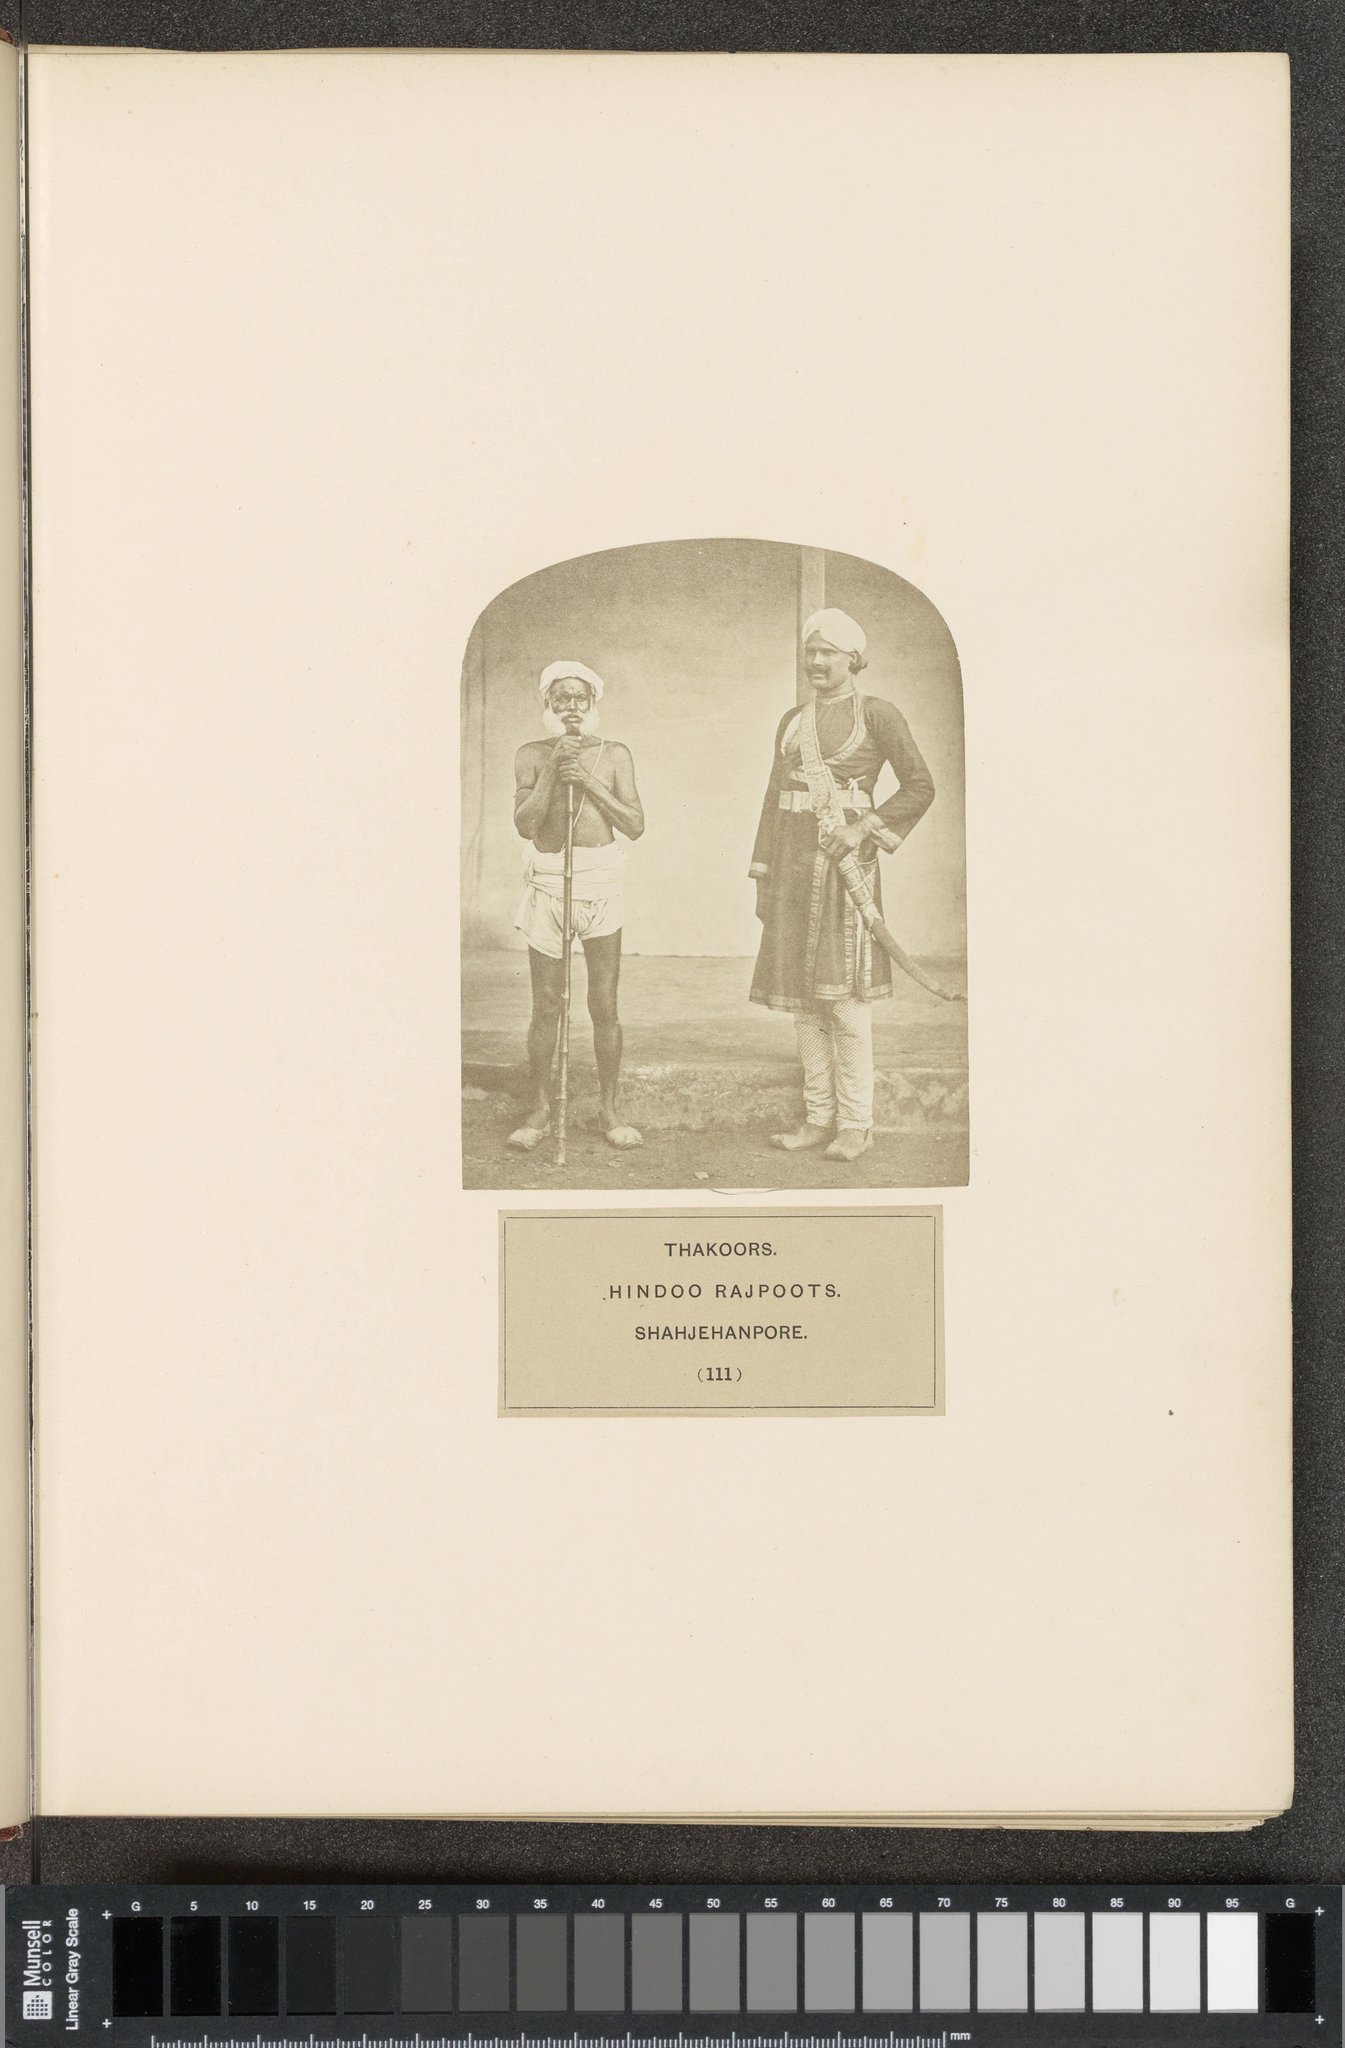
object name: page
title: Portrait of two unknown men from the Thakur community of Shahjahanpur, Uttar Pradesh, India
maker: Anonymous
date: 1858-1868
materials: photographic support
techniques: albumen print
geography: shahjahanpur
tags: human races; peoples; nationalities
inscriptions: number: ‘(111)’, inscription: ‘THAKOORS./ HINDOO RAJPOOTS./ SHAHJEHANPORE.’